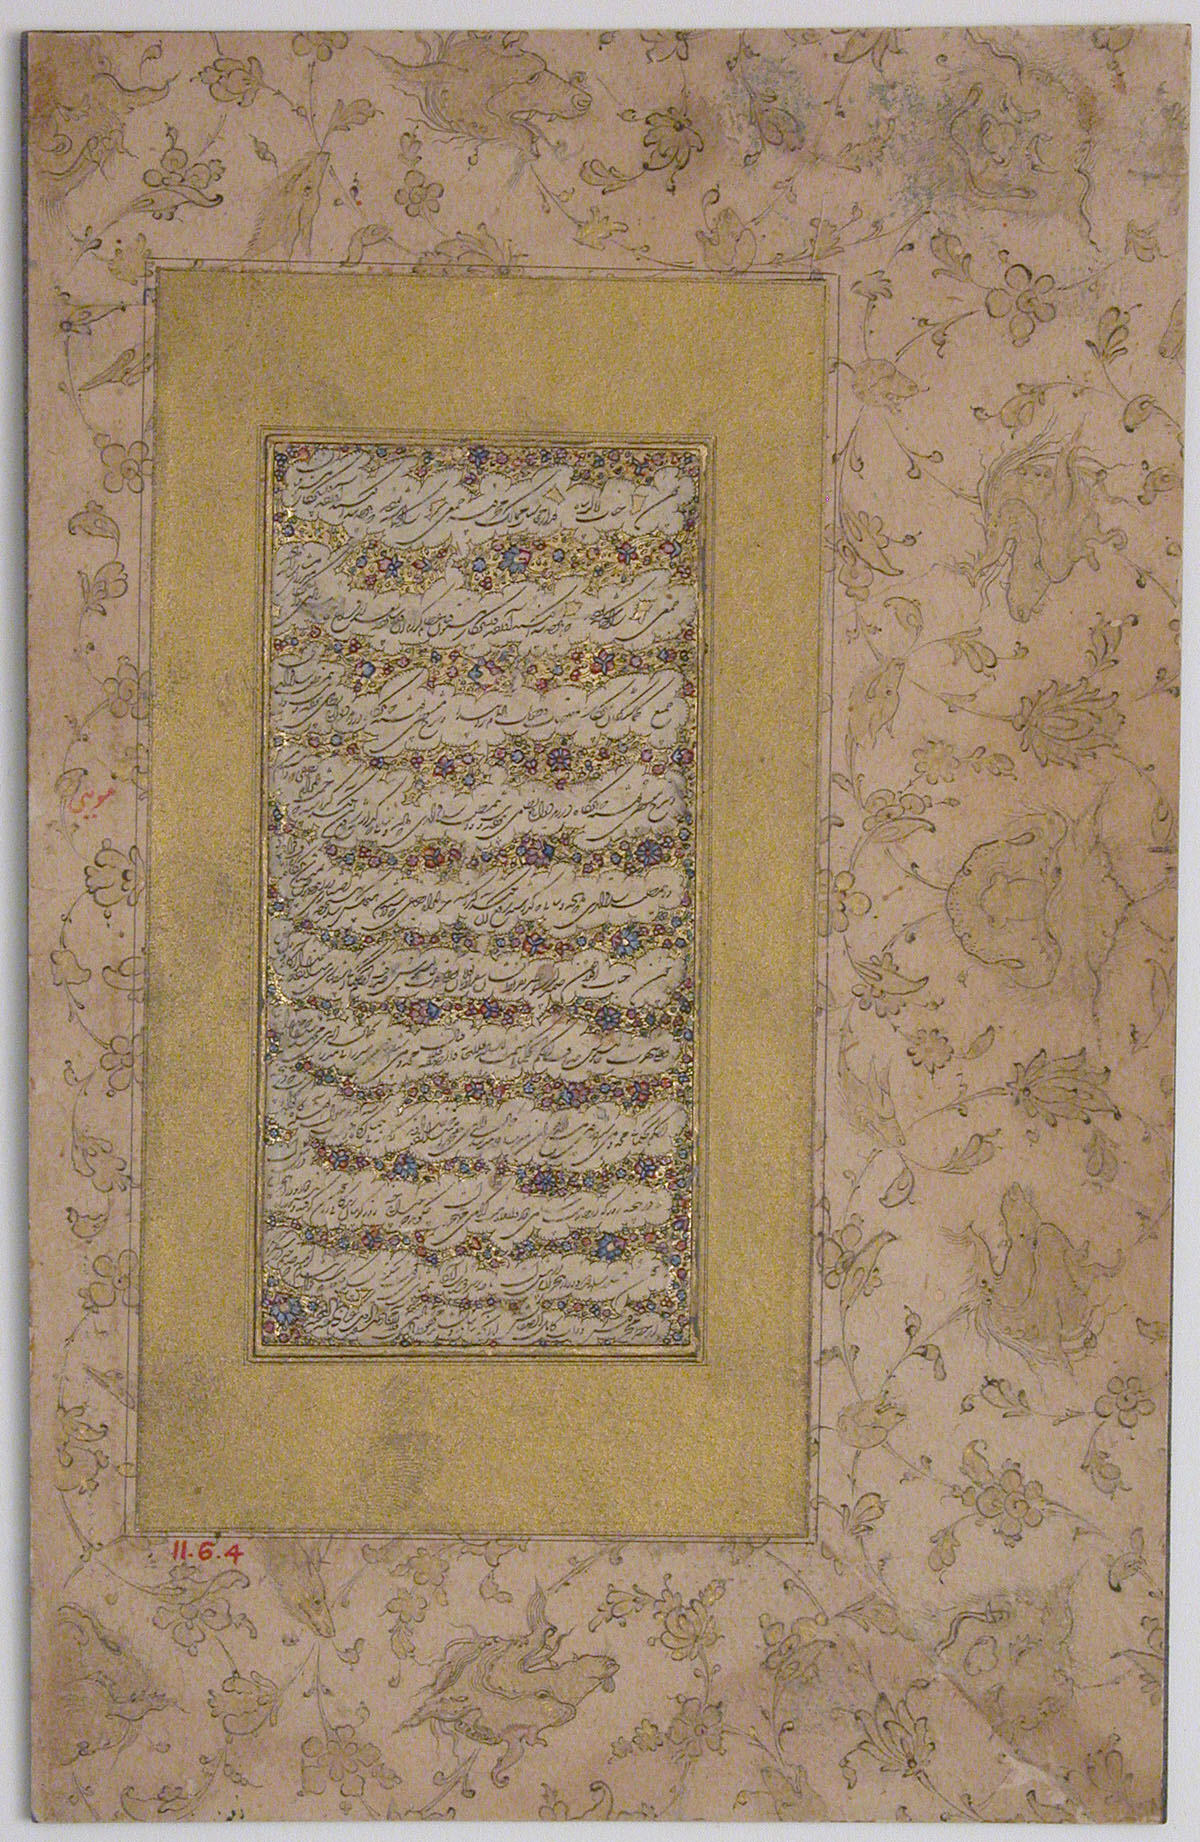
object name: folio from a non illustrated manuscript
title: Darvish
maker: abd al-majid taleqani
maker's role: calligrapher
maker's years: 1712-1796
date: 1701-1800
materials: gold, ink, paper, watercolor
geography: iran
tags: flowers